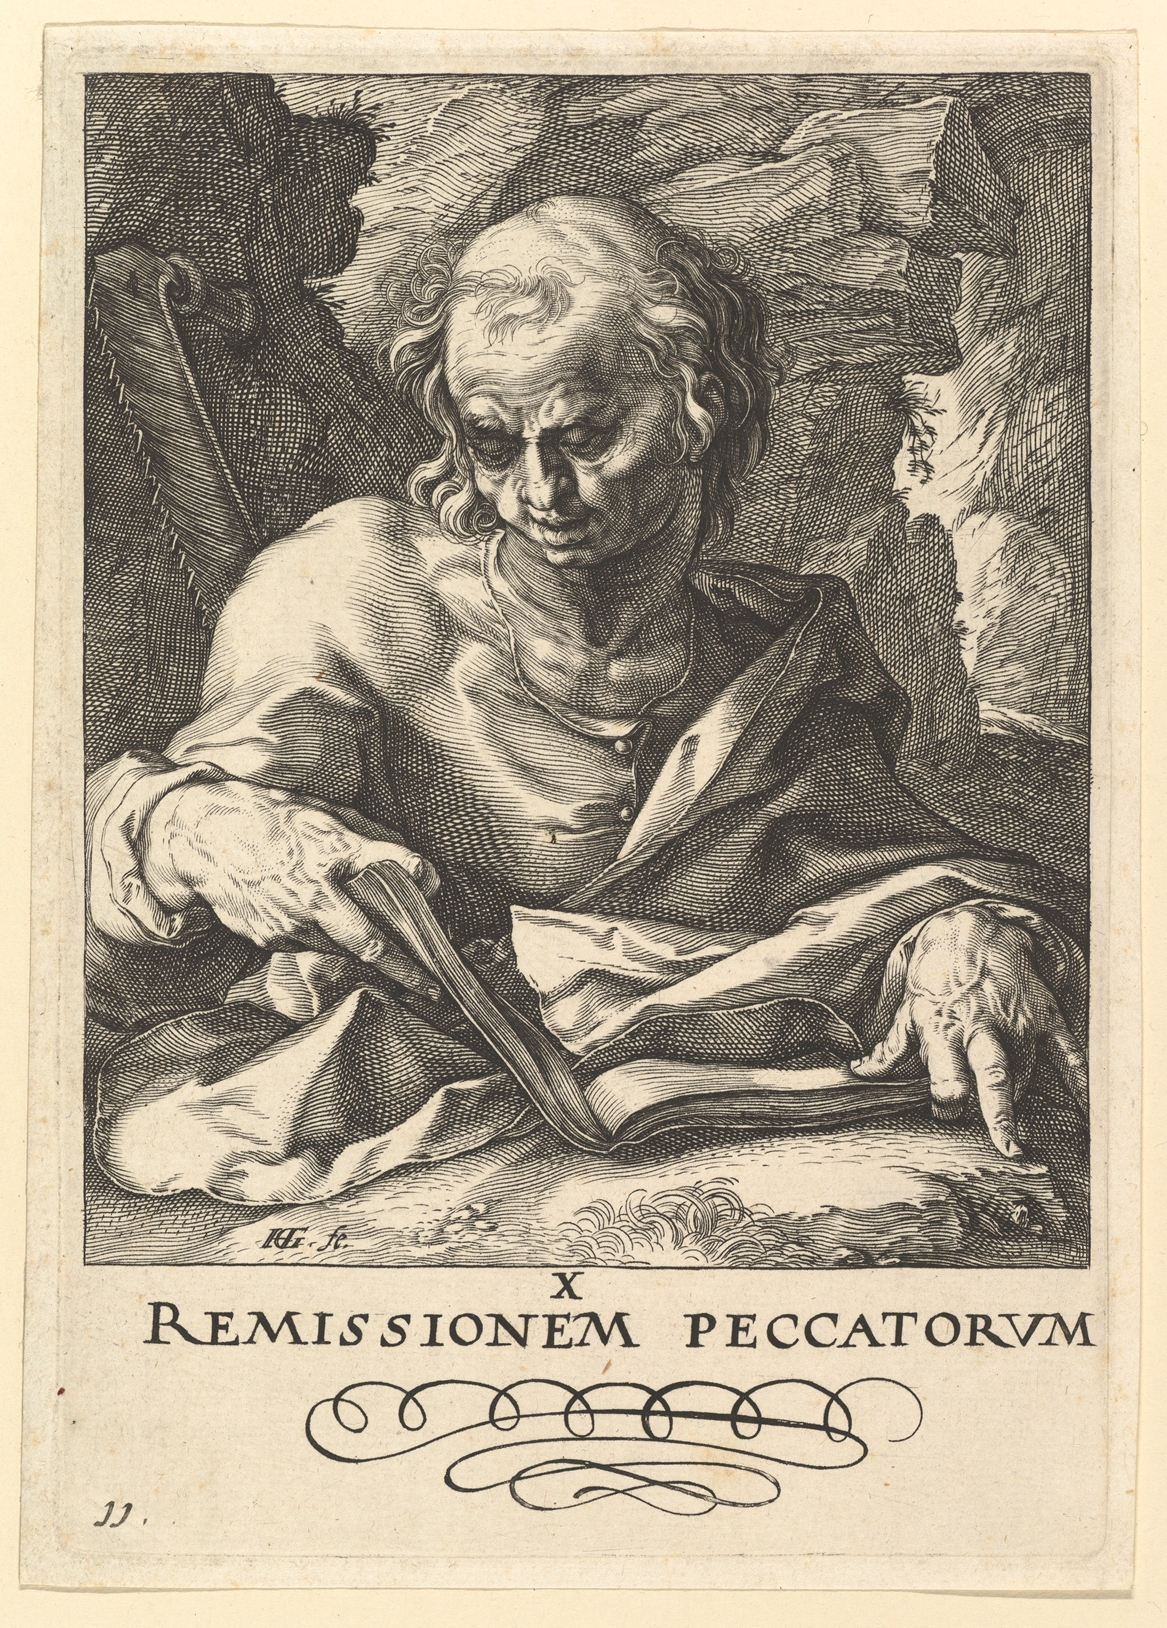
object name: print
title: St. Simon, from "Christ, the Apostles and St. Paul with the Creed"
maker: hendrick goltzius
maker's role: artist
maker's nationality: netherlandish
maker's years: 1558-1617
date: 1589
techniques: engraving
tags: men,saints